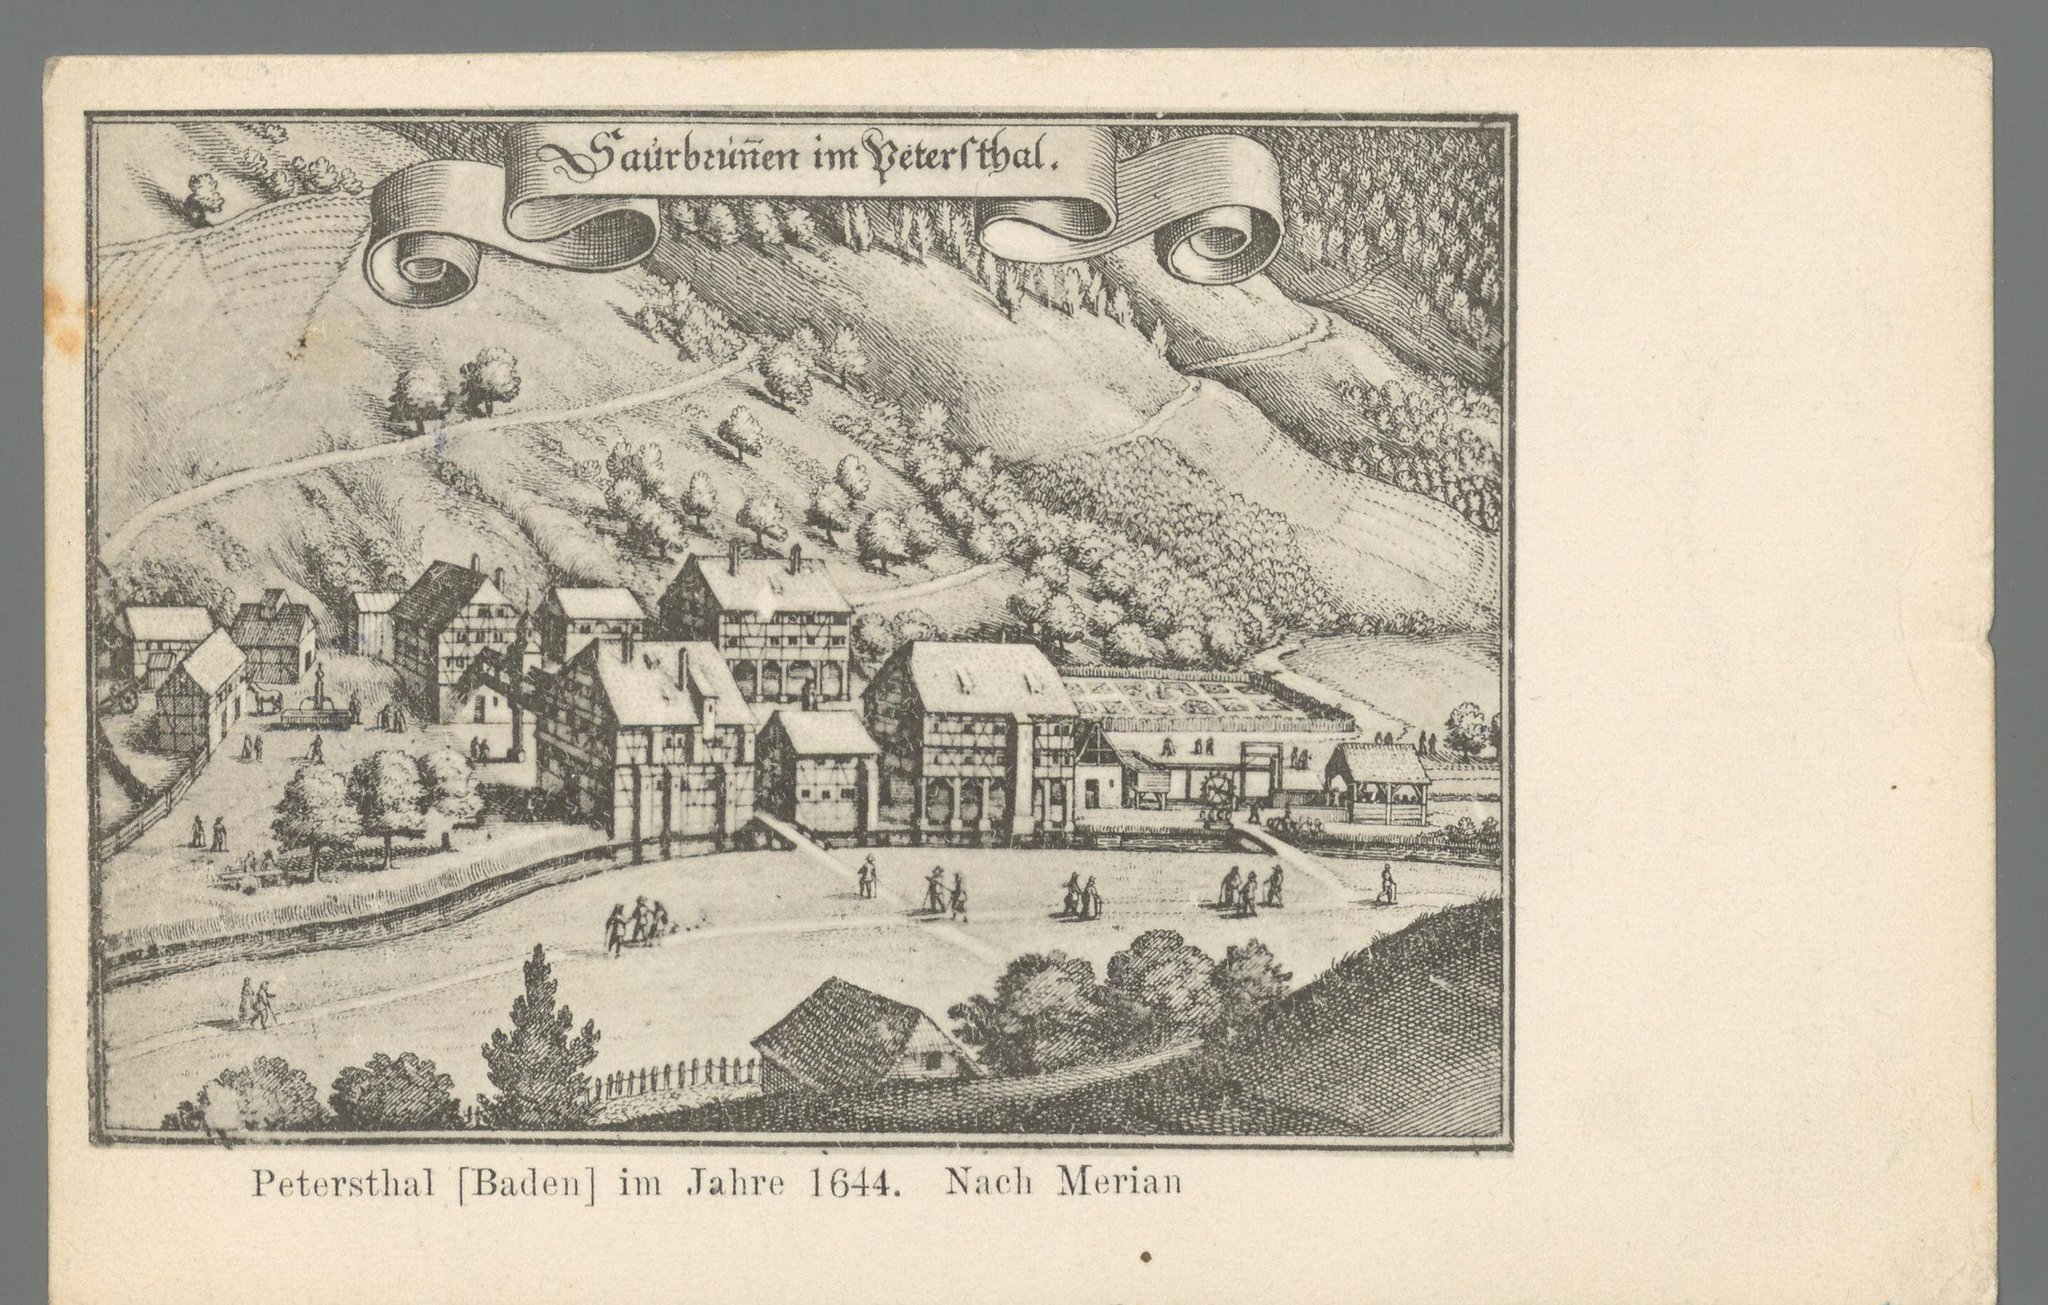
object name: reproduction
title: Petersthal [Baden] im Jahre 1644. Nach Merian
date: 1905-1907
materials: cardboard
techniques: photograph, writing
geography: frankfurt am main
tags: city-view, and landscape with man-made constructions, watering-place, spa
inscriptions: postage stamp